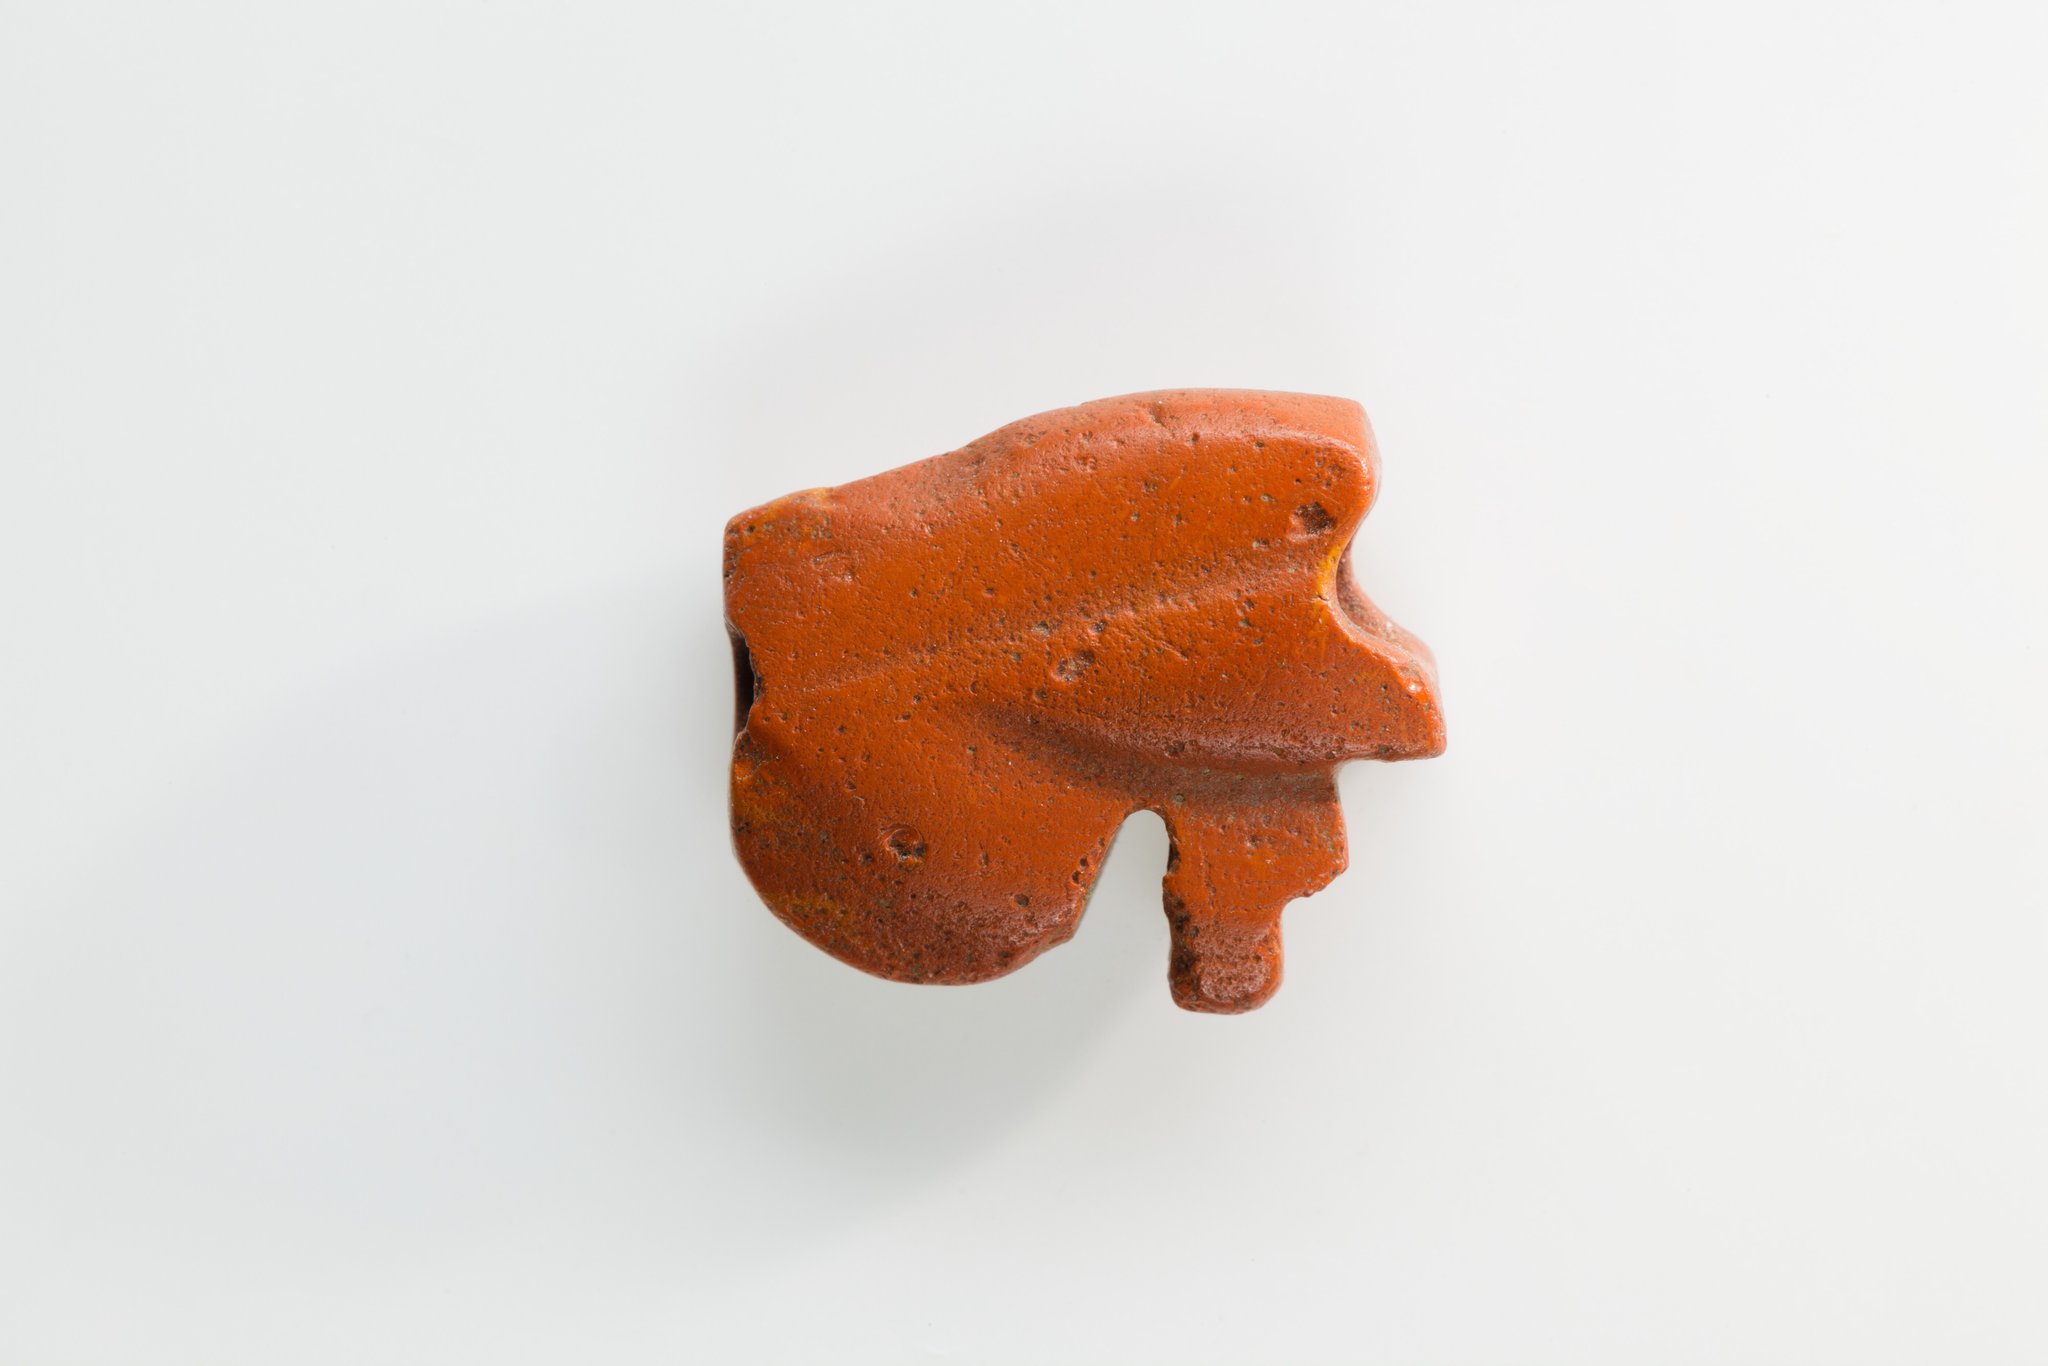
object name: amulet, wedjat eye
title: Wedjat eye amulet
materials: jasper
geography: egypt